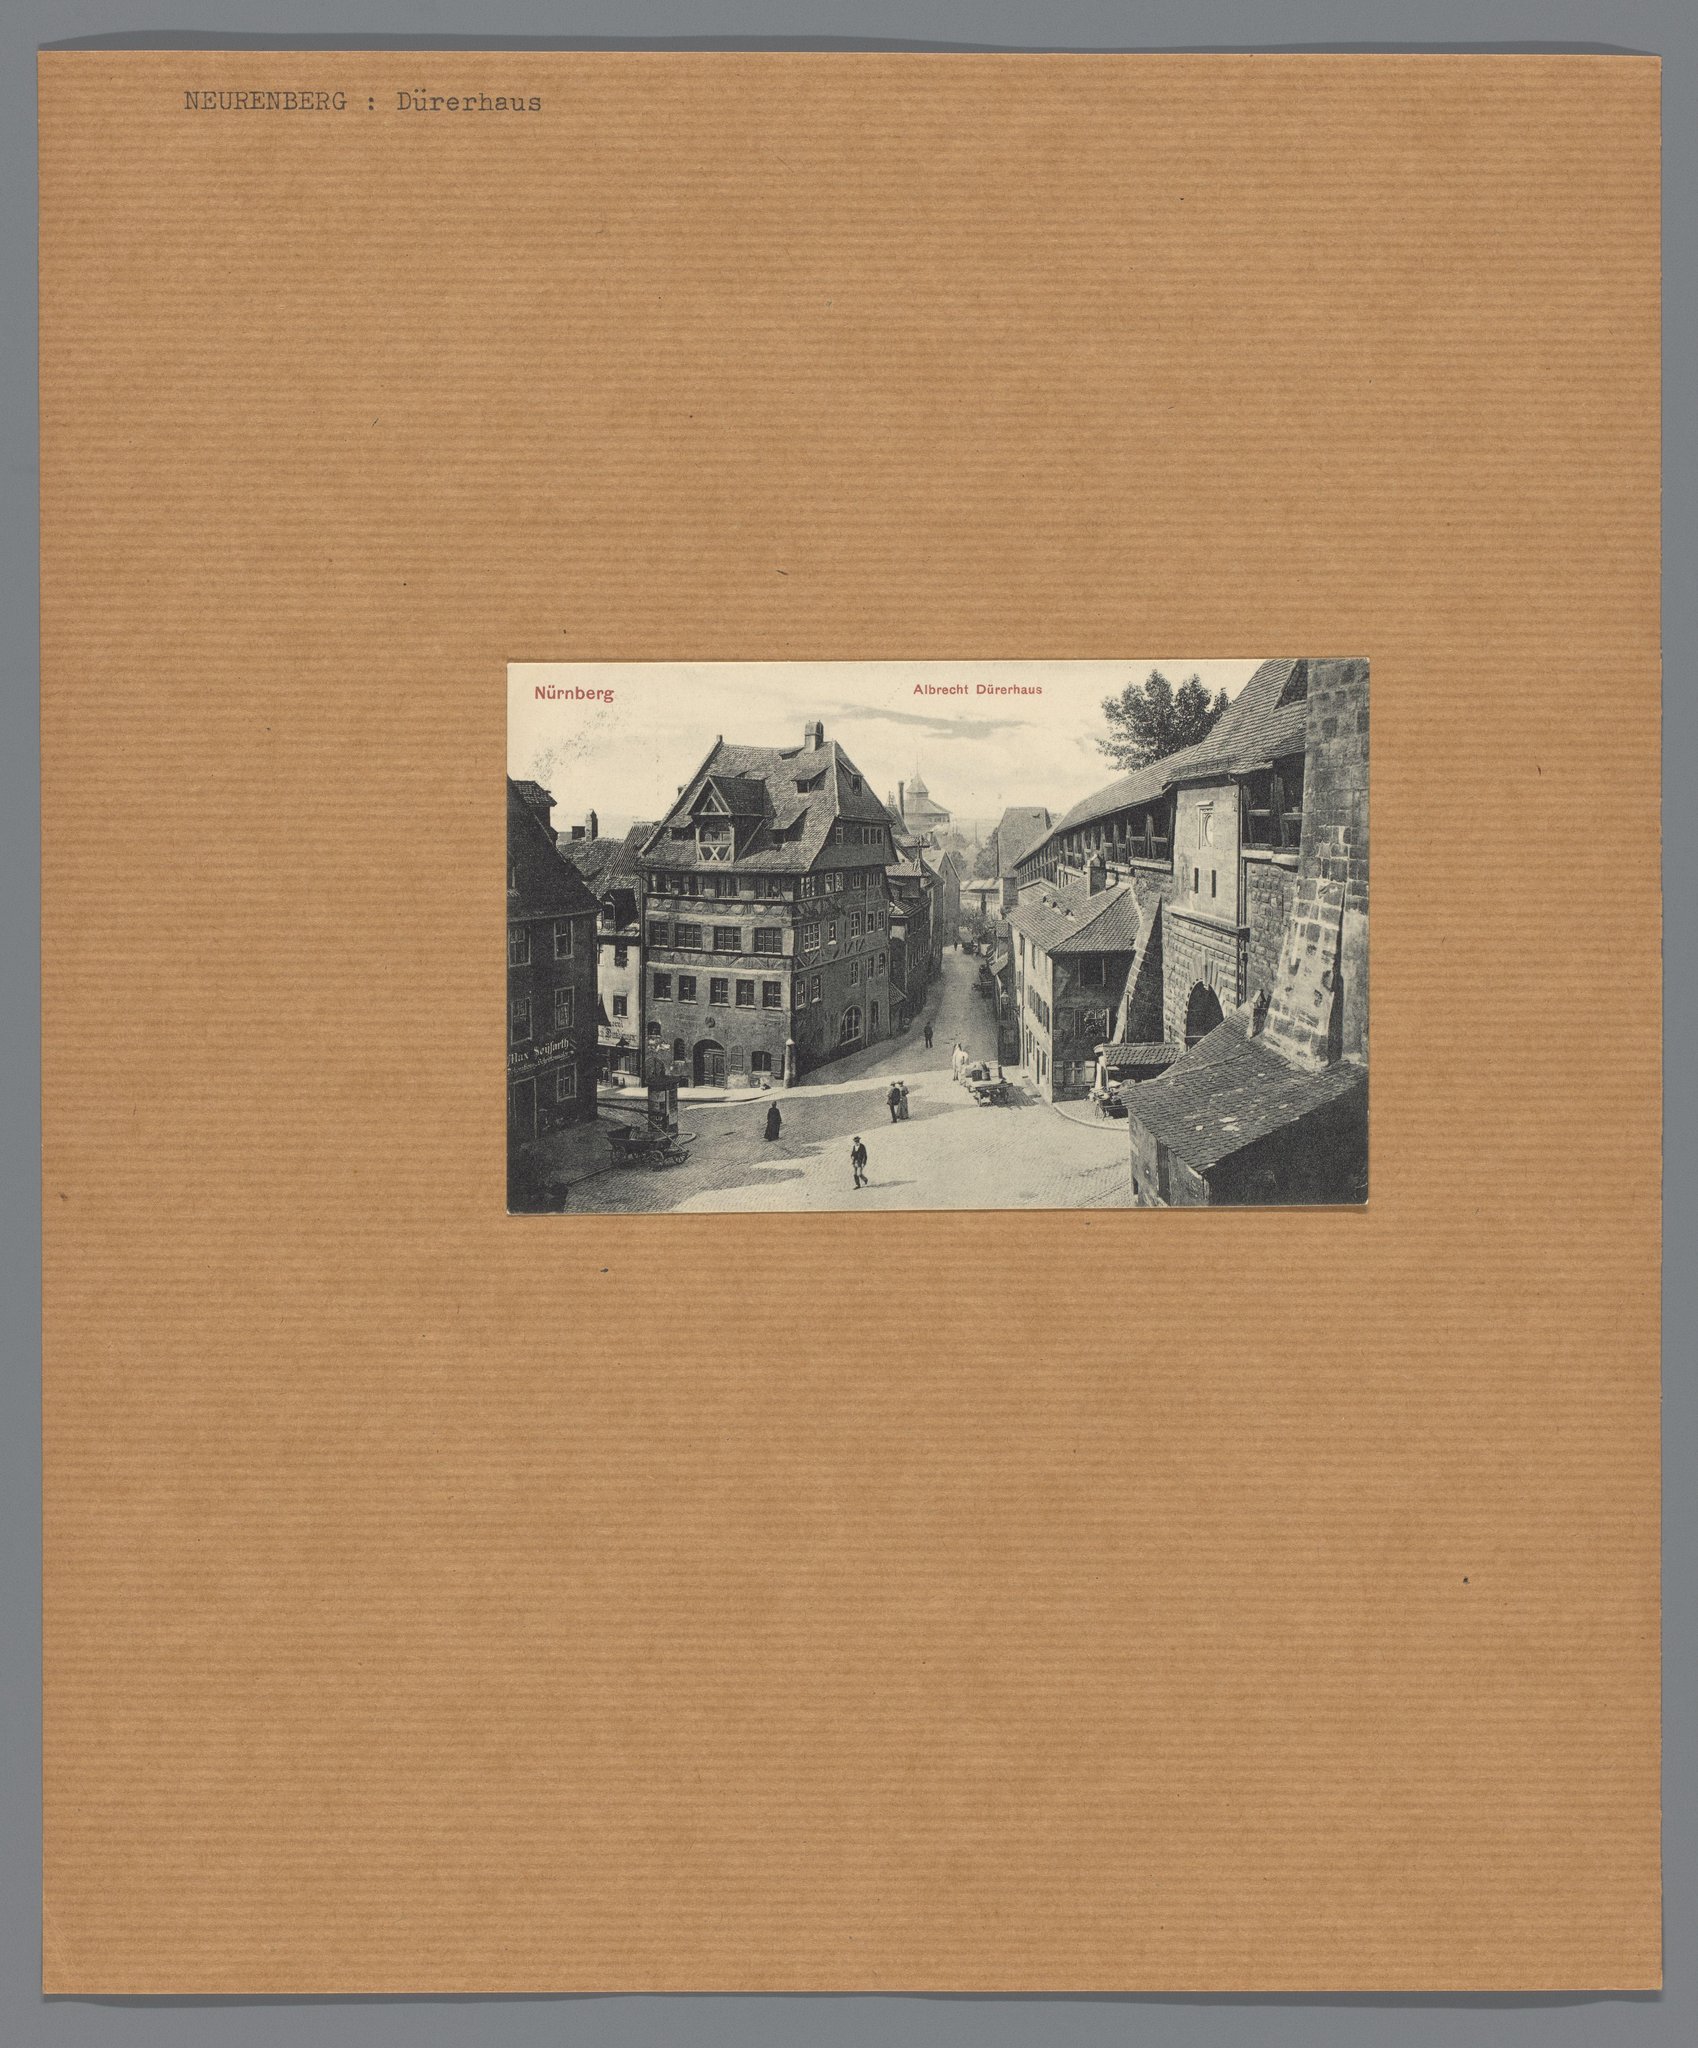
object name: photograph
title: Nürnberg (Neurenberg) Dürerhaus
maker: Anonymous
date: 1880-1920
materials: paper, photographic support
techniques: photograph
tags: neurenberg